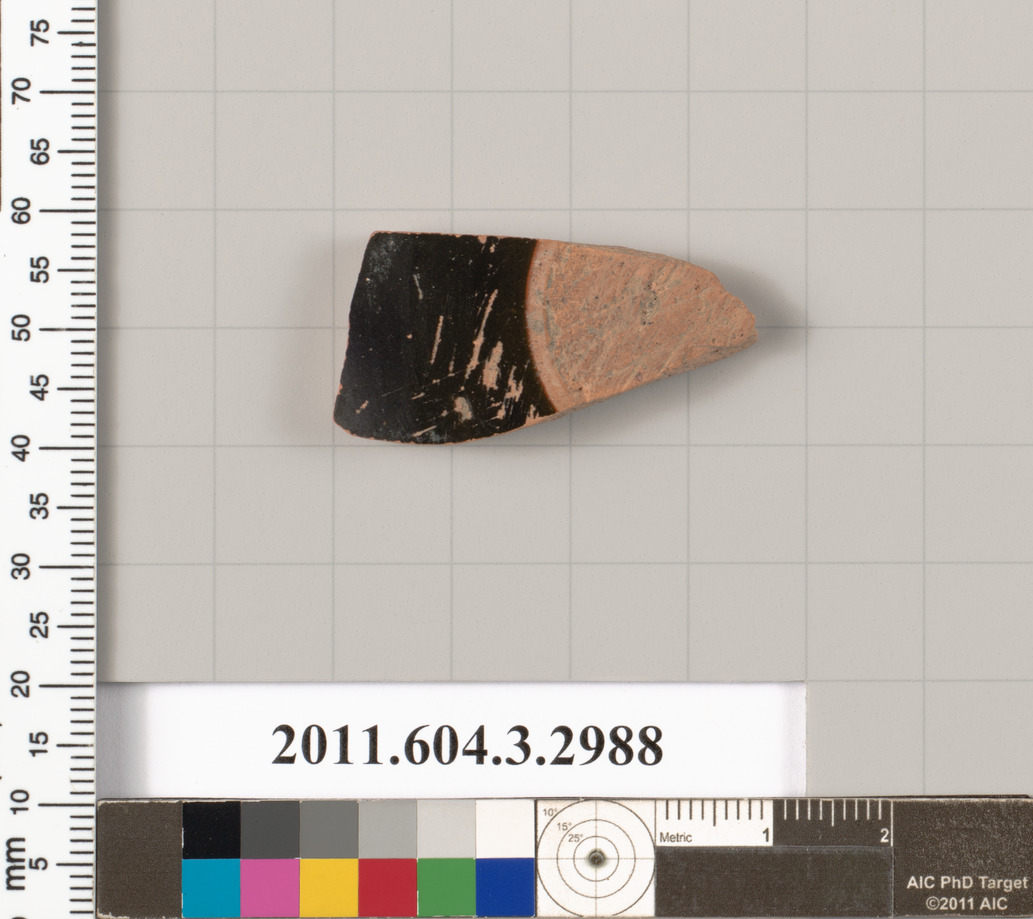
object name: undetermined open shape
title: Terracotta fragment of an open shape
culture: greek, attic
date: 600-501 BCE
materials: terracotta